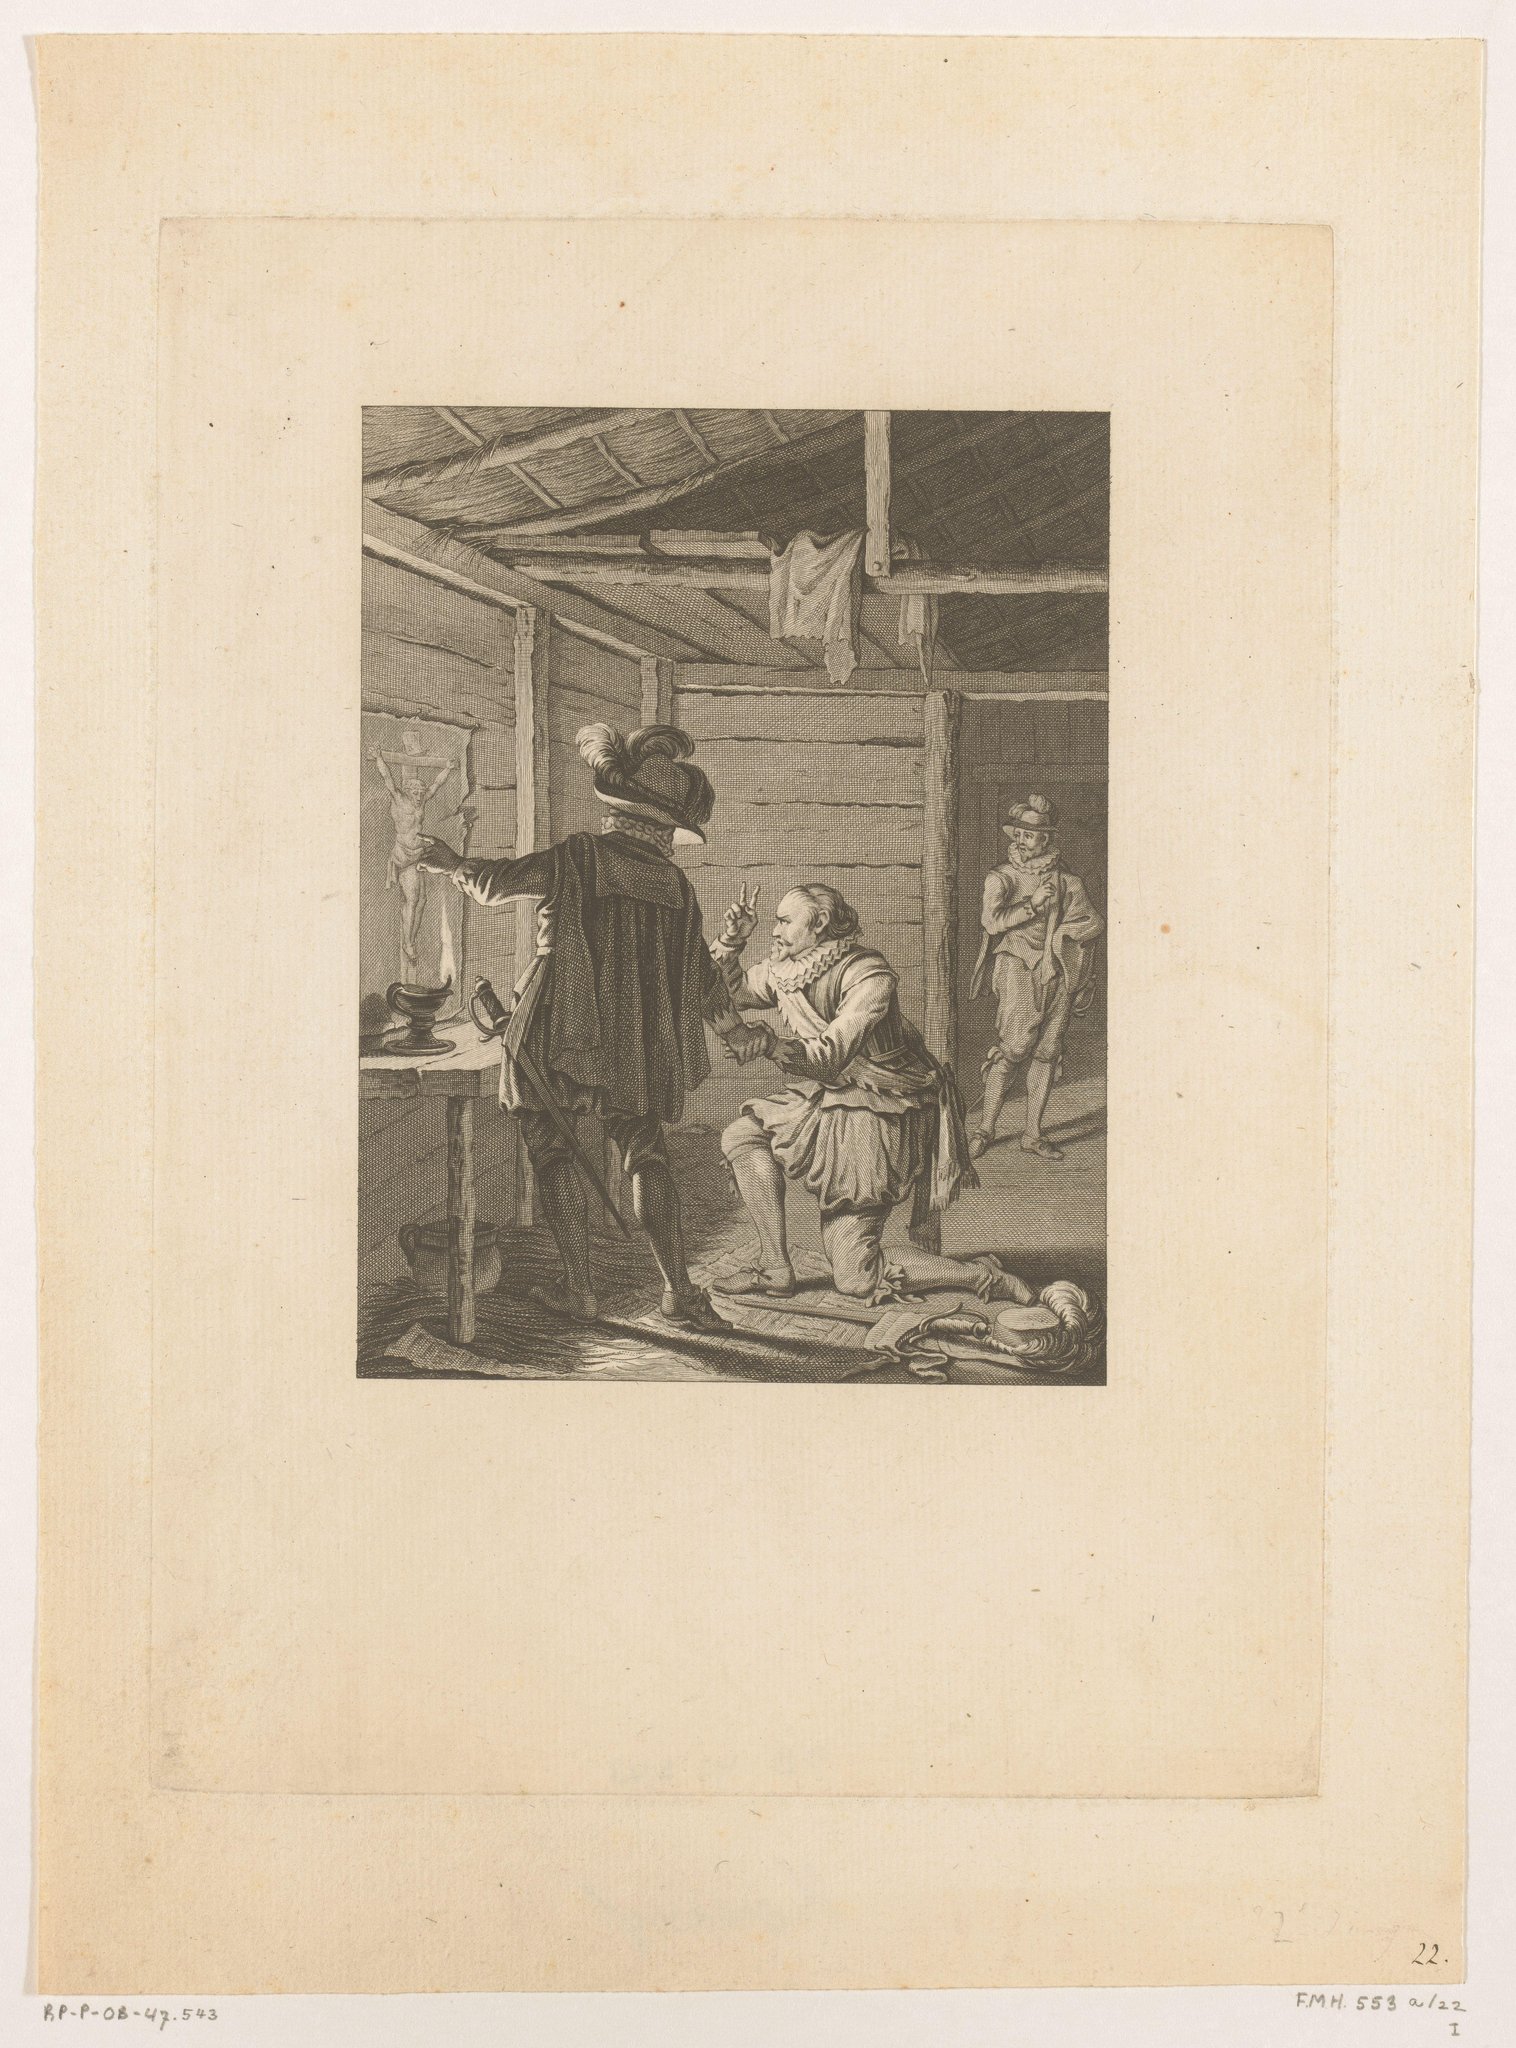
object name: print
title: Het verraad van Rennenberg, 1580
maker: theodoor koning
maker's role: print maker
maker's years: 1748-1829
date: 1787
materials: paper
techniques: engraving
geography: amsterdam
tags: groningen (province), politician, rome, alessandro farnese (landvoogd van de nederlanden en hertog van parma en piacenza), altarcross, crucifix, print, e.g.: engraving, etching, lithograph, swearing an oath (with two fingers raised)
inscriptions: inscription: ‘22’, collector's mark: Lugt 2228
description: Rennenberg zweert 's nachts geknield voor een afbeelding van Christus aan het kruis, trouw aan Spanje terwijl Farnese naast hem staat, 1580. Deze prent maakt deel uit van een serie van 24 prenten met taferelen uit het leven van prins Willem I, 1568-1584 en is een illustratie bij de tweeëntwintigste zang.